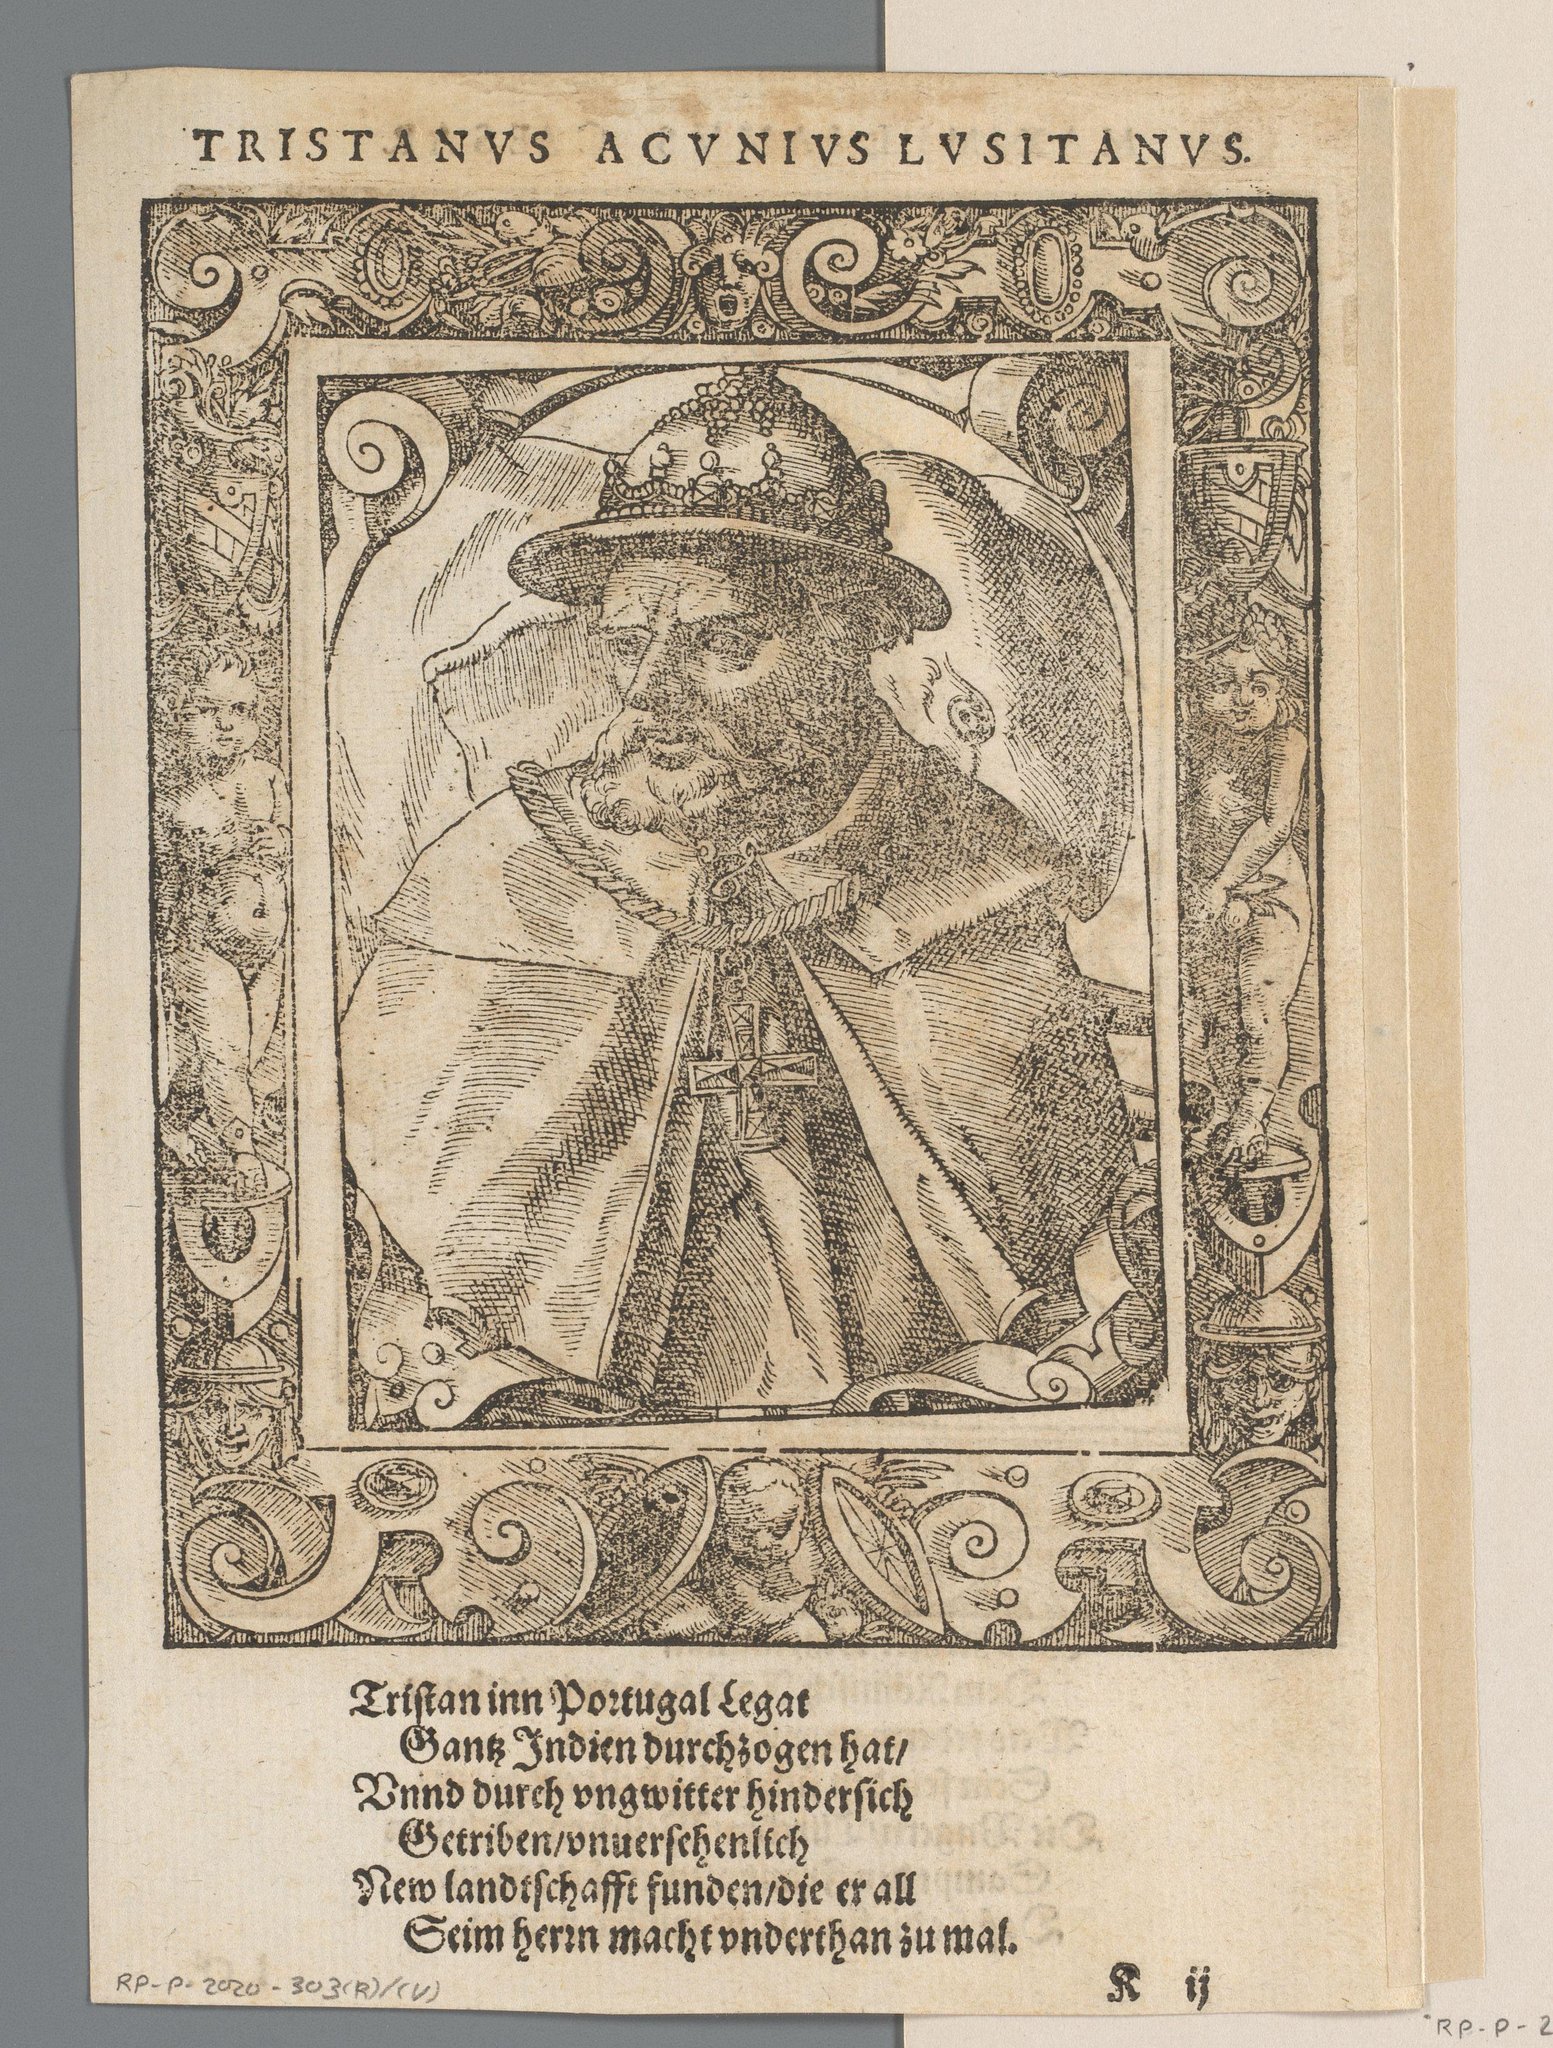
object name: print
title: Portret van Tristão da Cunha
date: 1577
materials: paper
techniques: letterpress printing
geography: basel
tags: historical persons, explorer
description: Prent uit: Müller, Theobald. Eigentliche und gedenkwürdige Contrafacturen oder Anbildungen wolverdienter unnd Weitberümter Kriegshelden, (...). Bazel: Peter Perna, 1577. Prent eerder verschenen in: Giovio, Paolo. Elogia virorum bellica virtute illustrium (...). Bazel: Peter Perna, 1575. Prent ook gebruikt in latere publicaties.